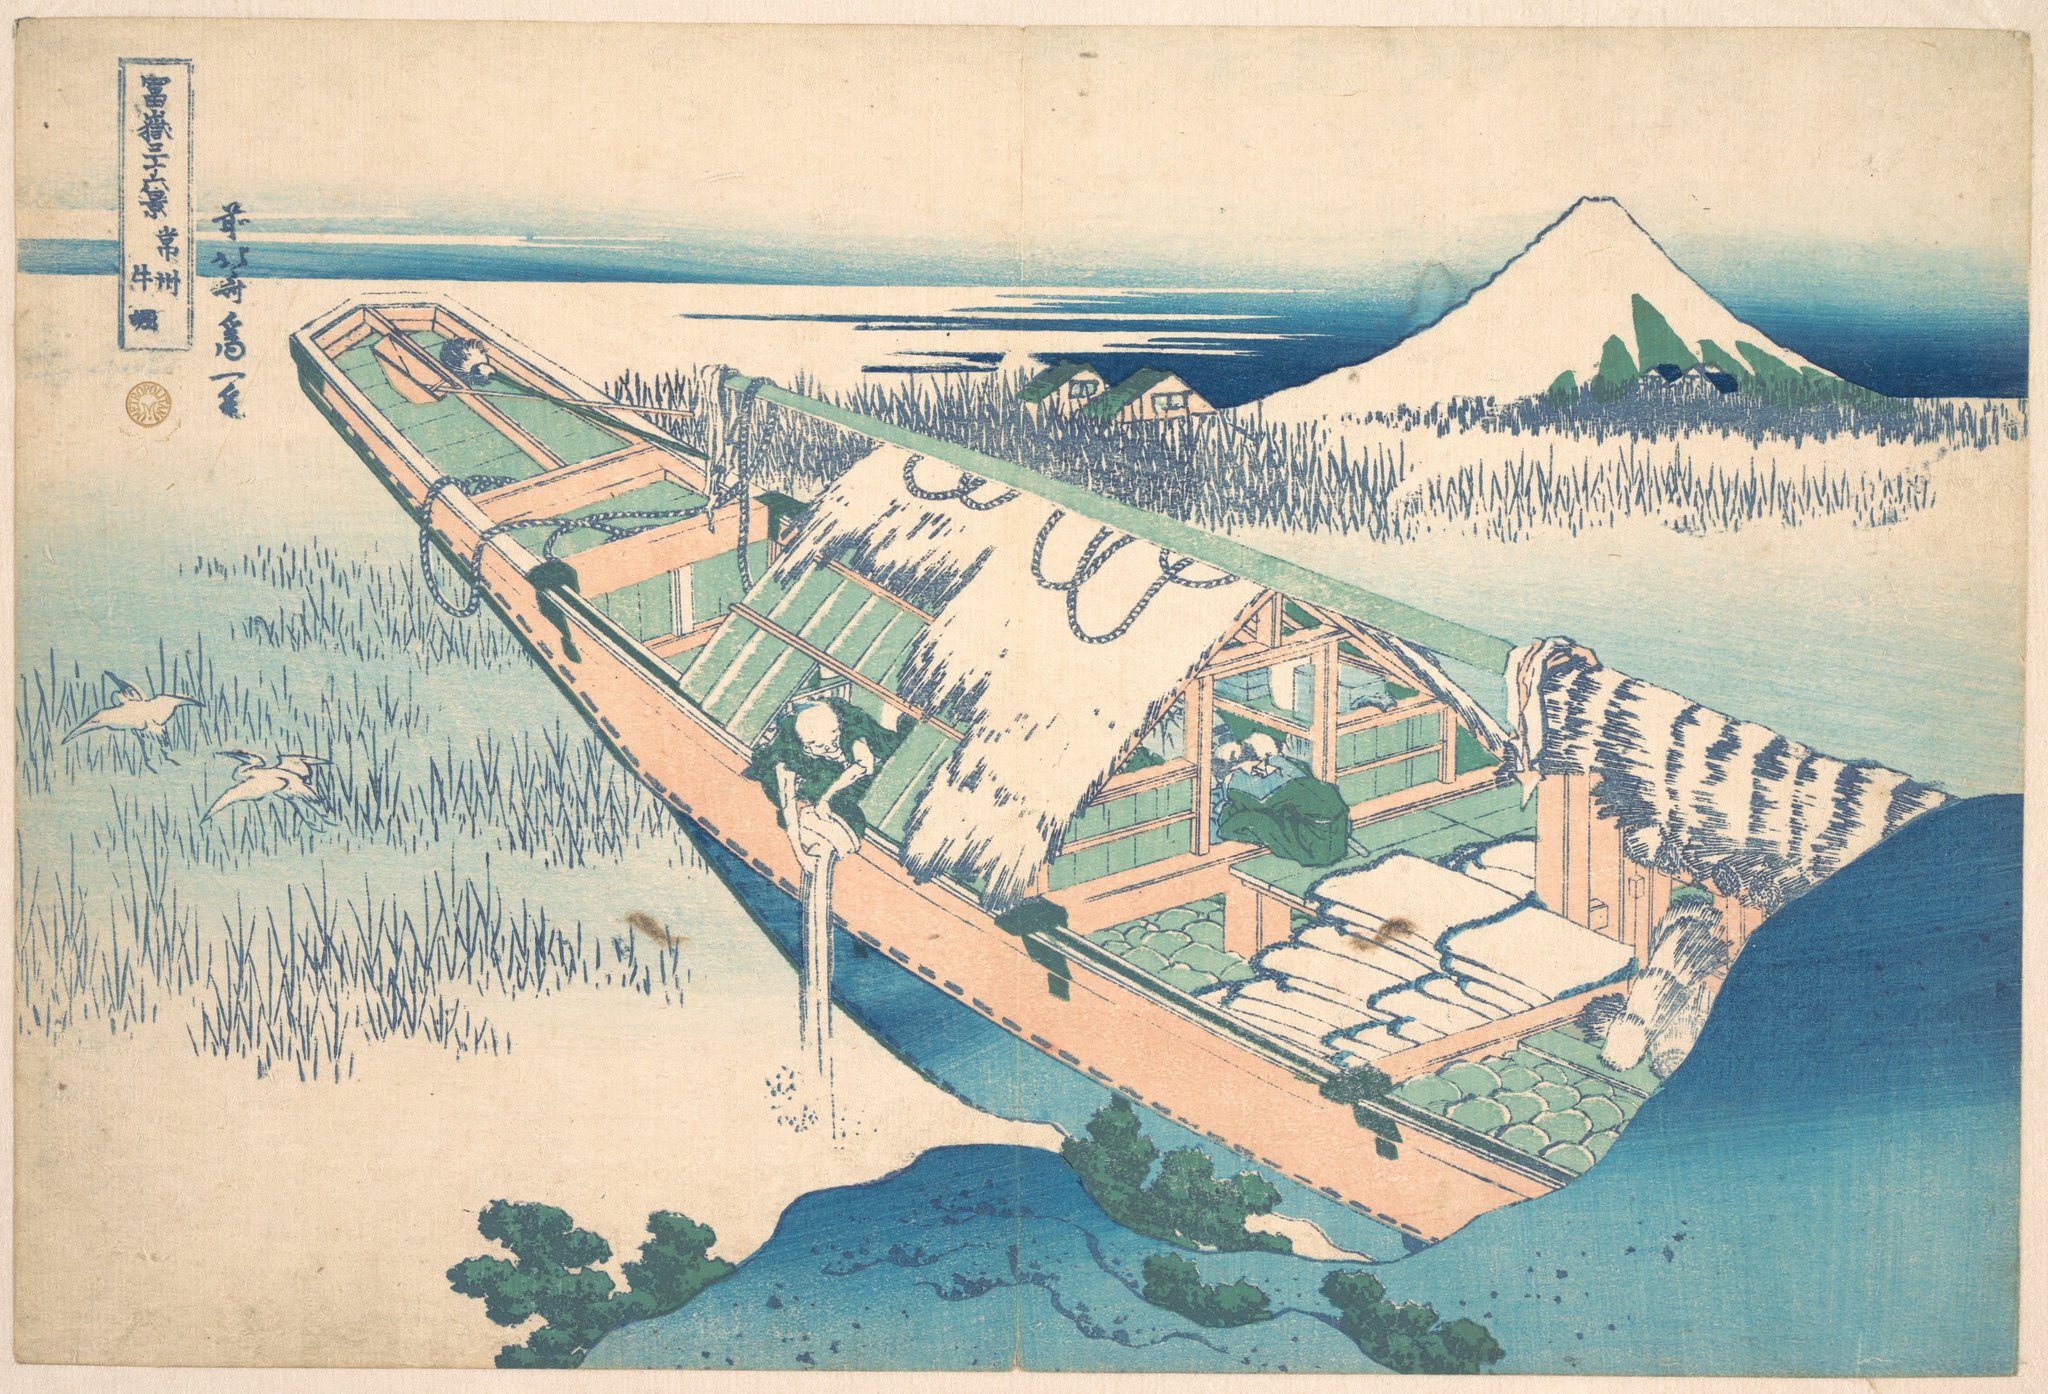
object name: woodblock print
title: Ushibori in Hitachi Province (Jōshū Ushibori), from the series Thirty-six Views of Mount Fuji (Fugaku sanjūrokkei)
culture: japanese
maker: katsushika hokusai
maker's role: artist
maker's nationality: japanese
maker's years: 1760-1849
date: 1830-1832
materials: ink, paper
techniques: woodblock print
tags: mountains,boats